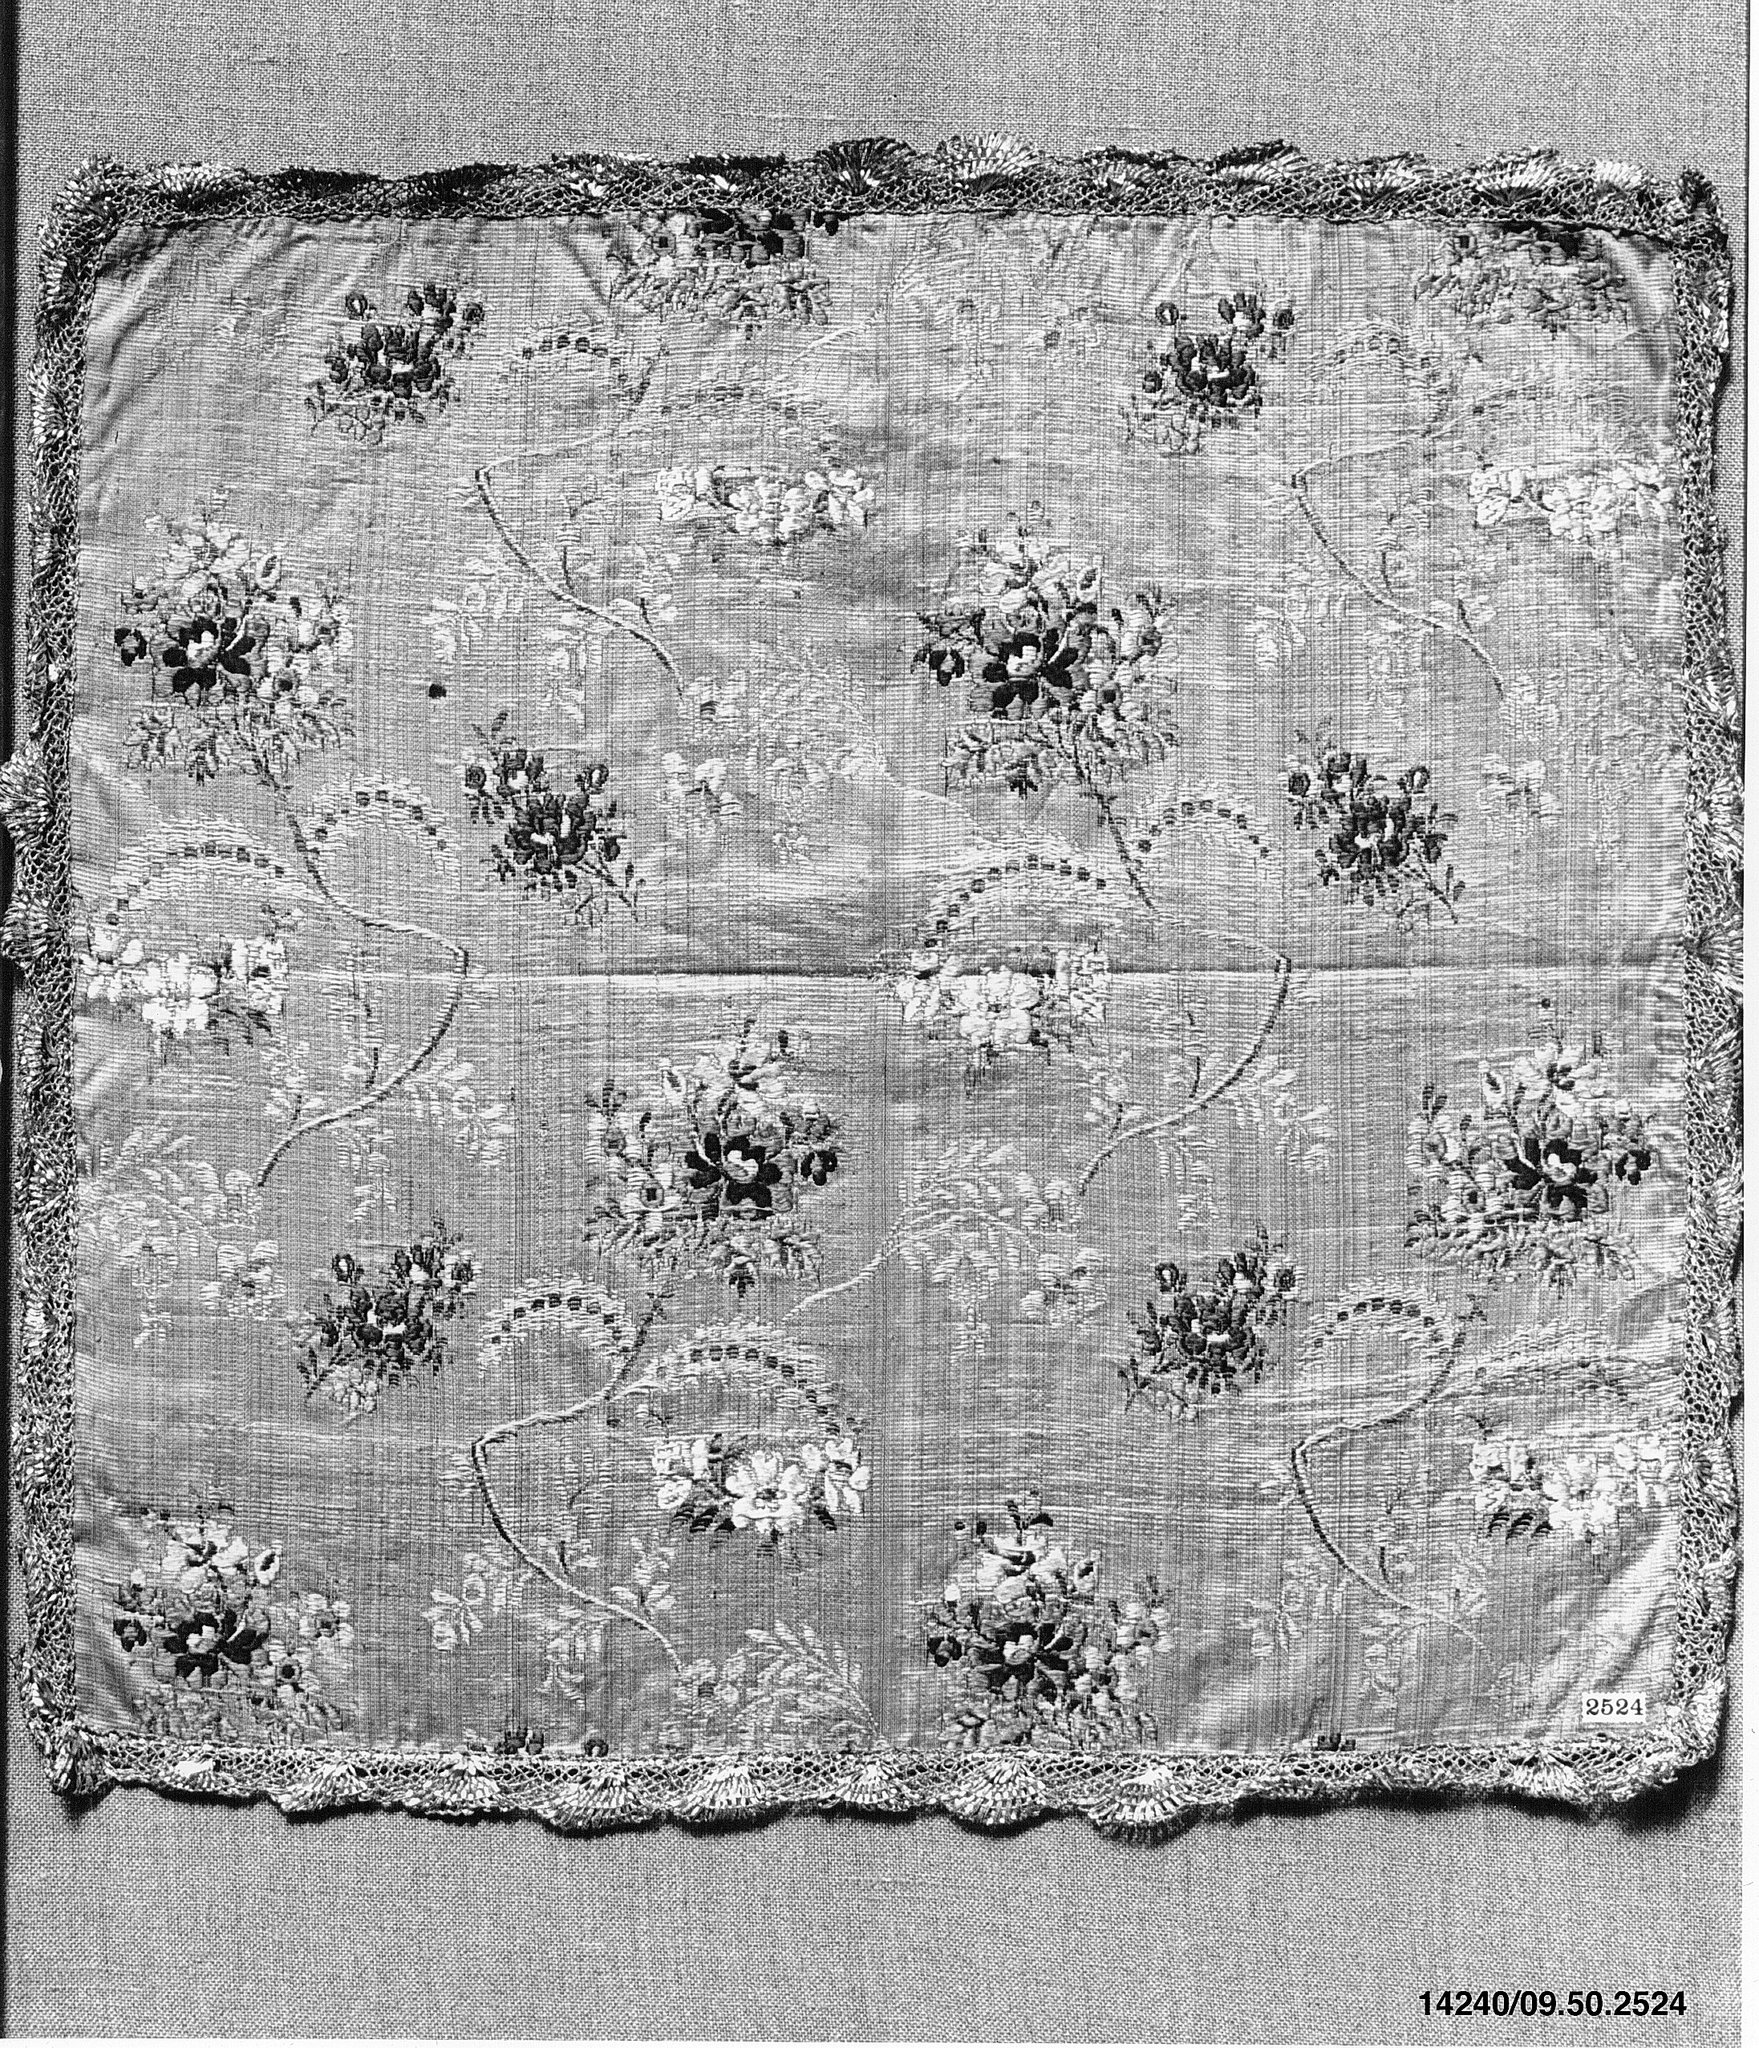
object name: piece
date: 1765-1770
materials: silk